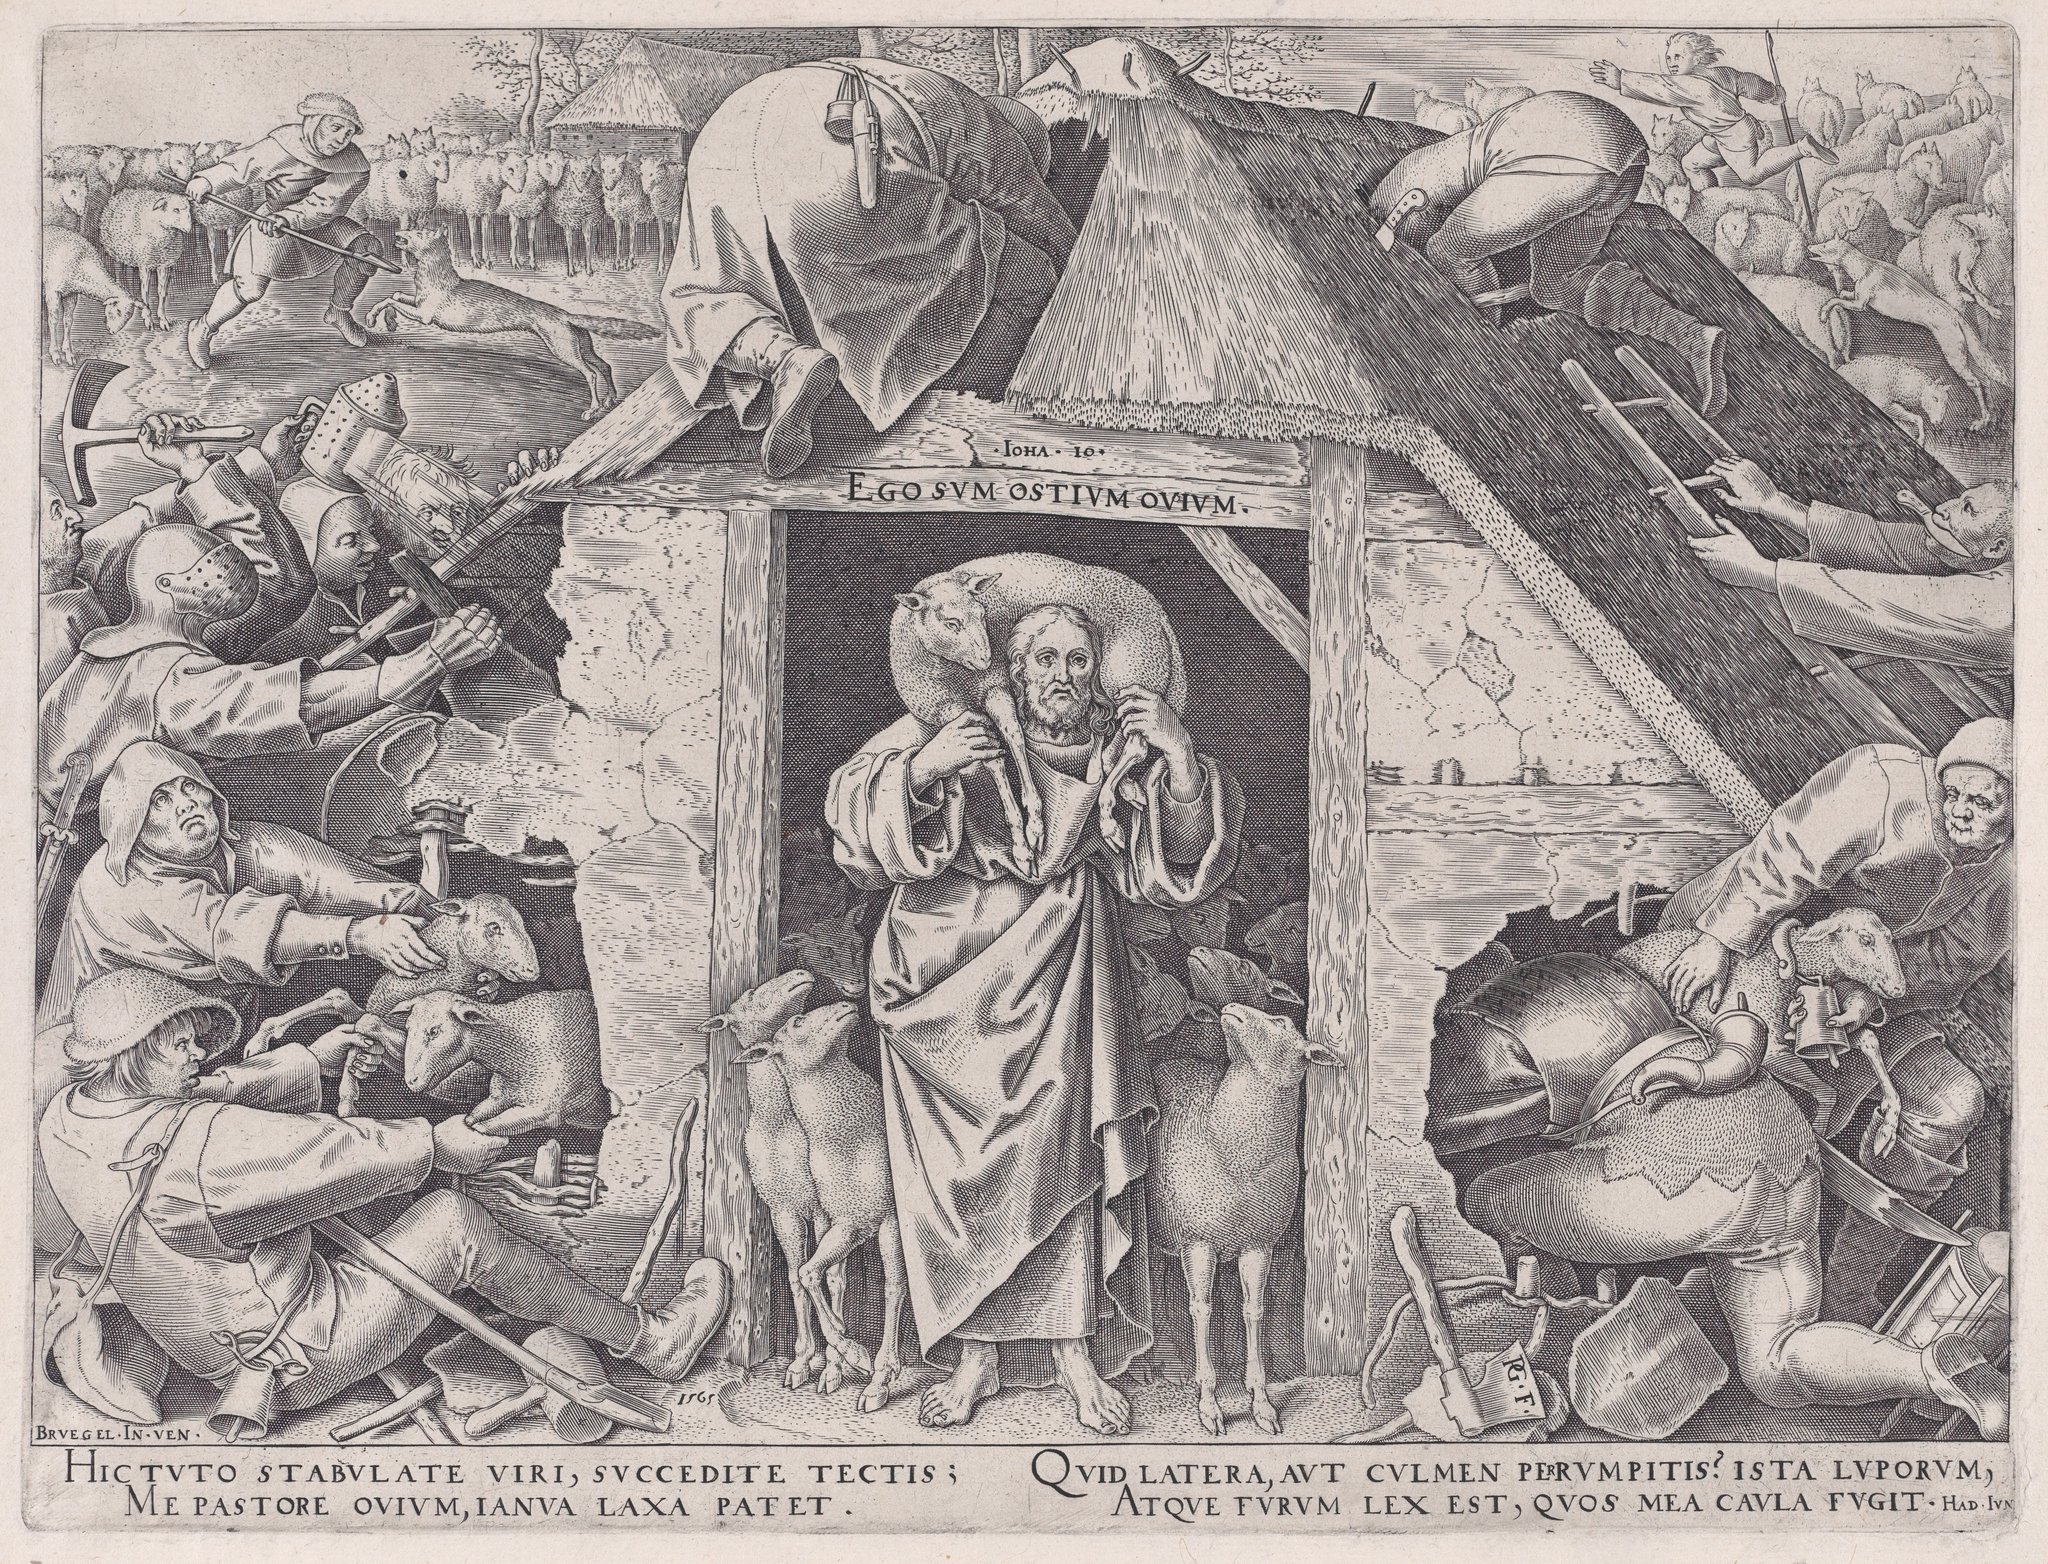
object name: print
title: Parable of the Good Shepherd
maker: philips galle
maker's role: artist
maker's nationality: netherlandish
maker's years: 1537-1612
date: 1565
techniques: engraving